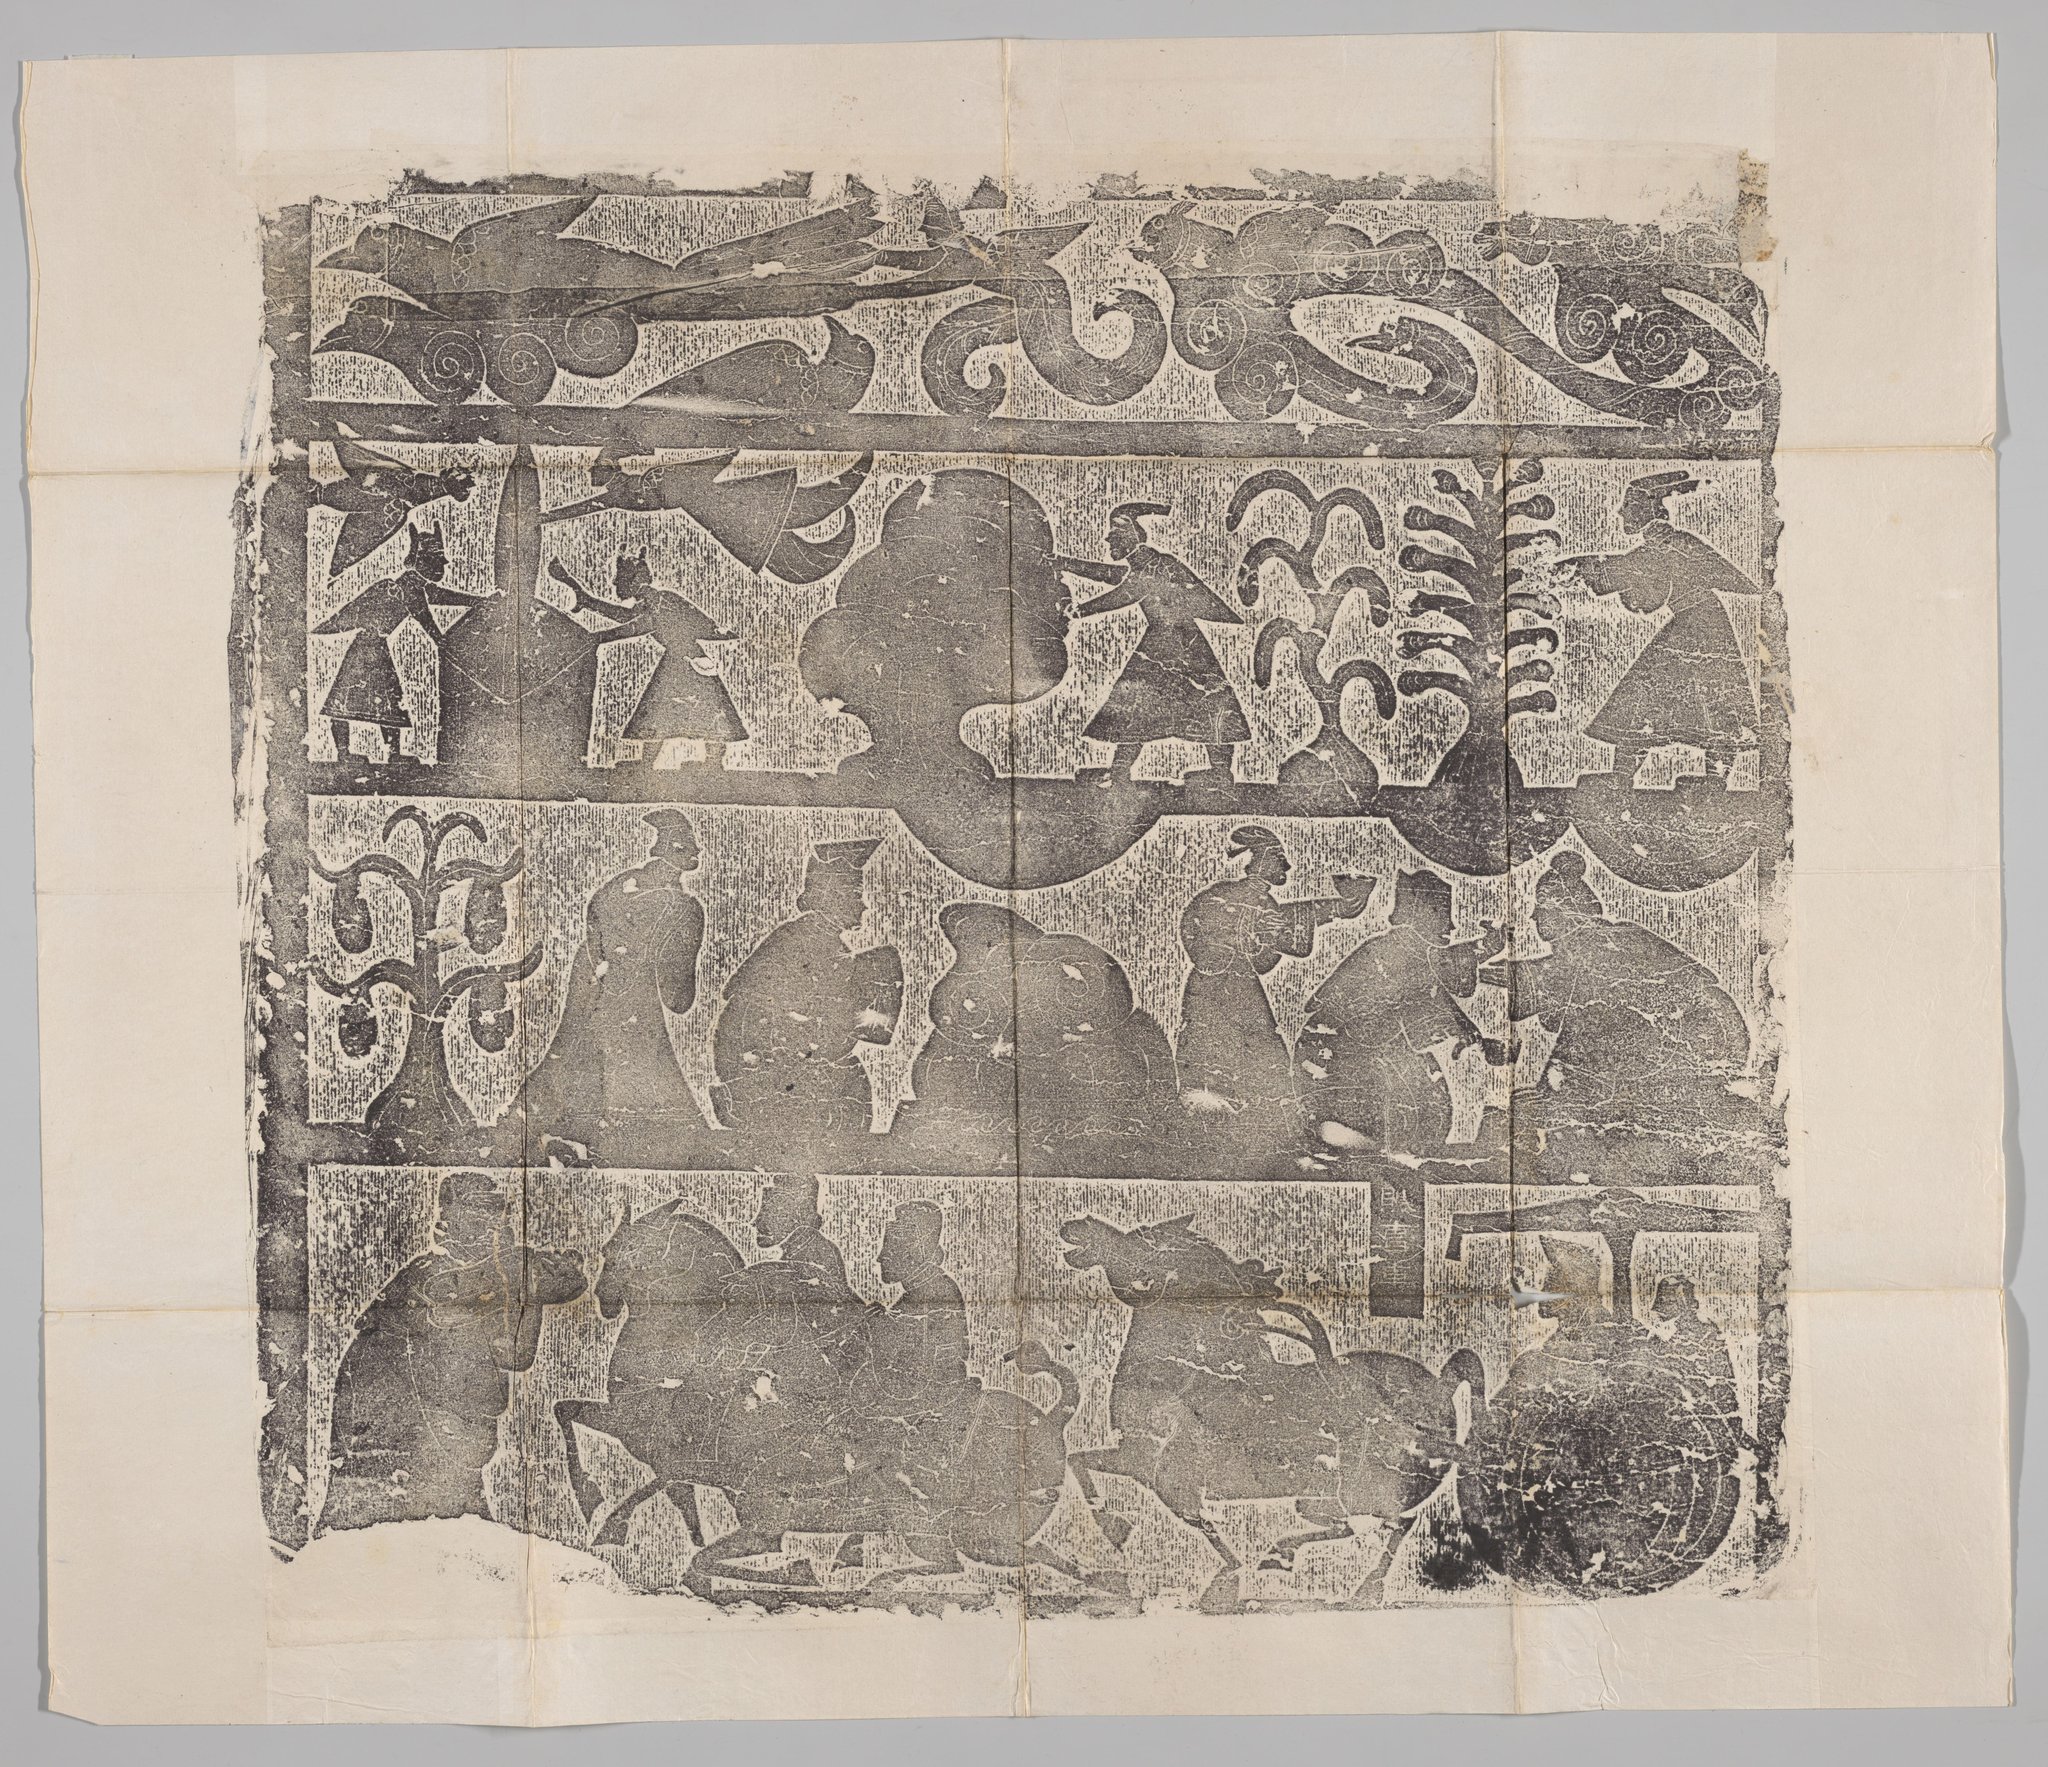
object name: wrijfprent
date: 1900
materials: ink, paper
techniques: rubbing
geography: china